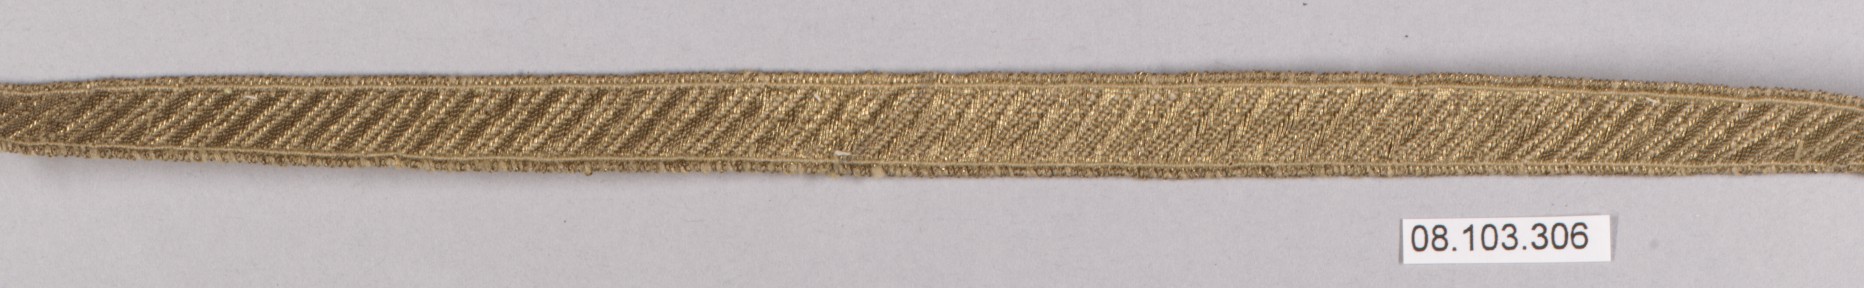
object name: galloon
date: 1601-1800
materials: metal thread